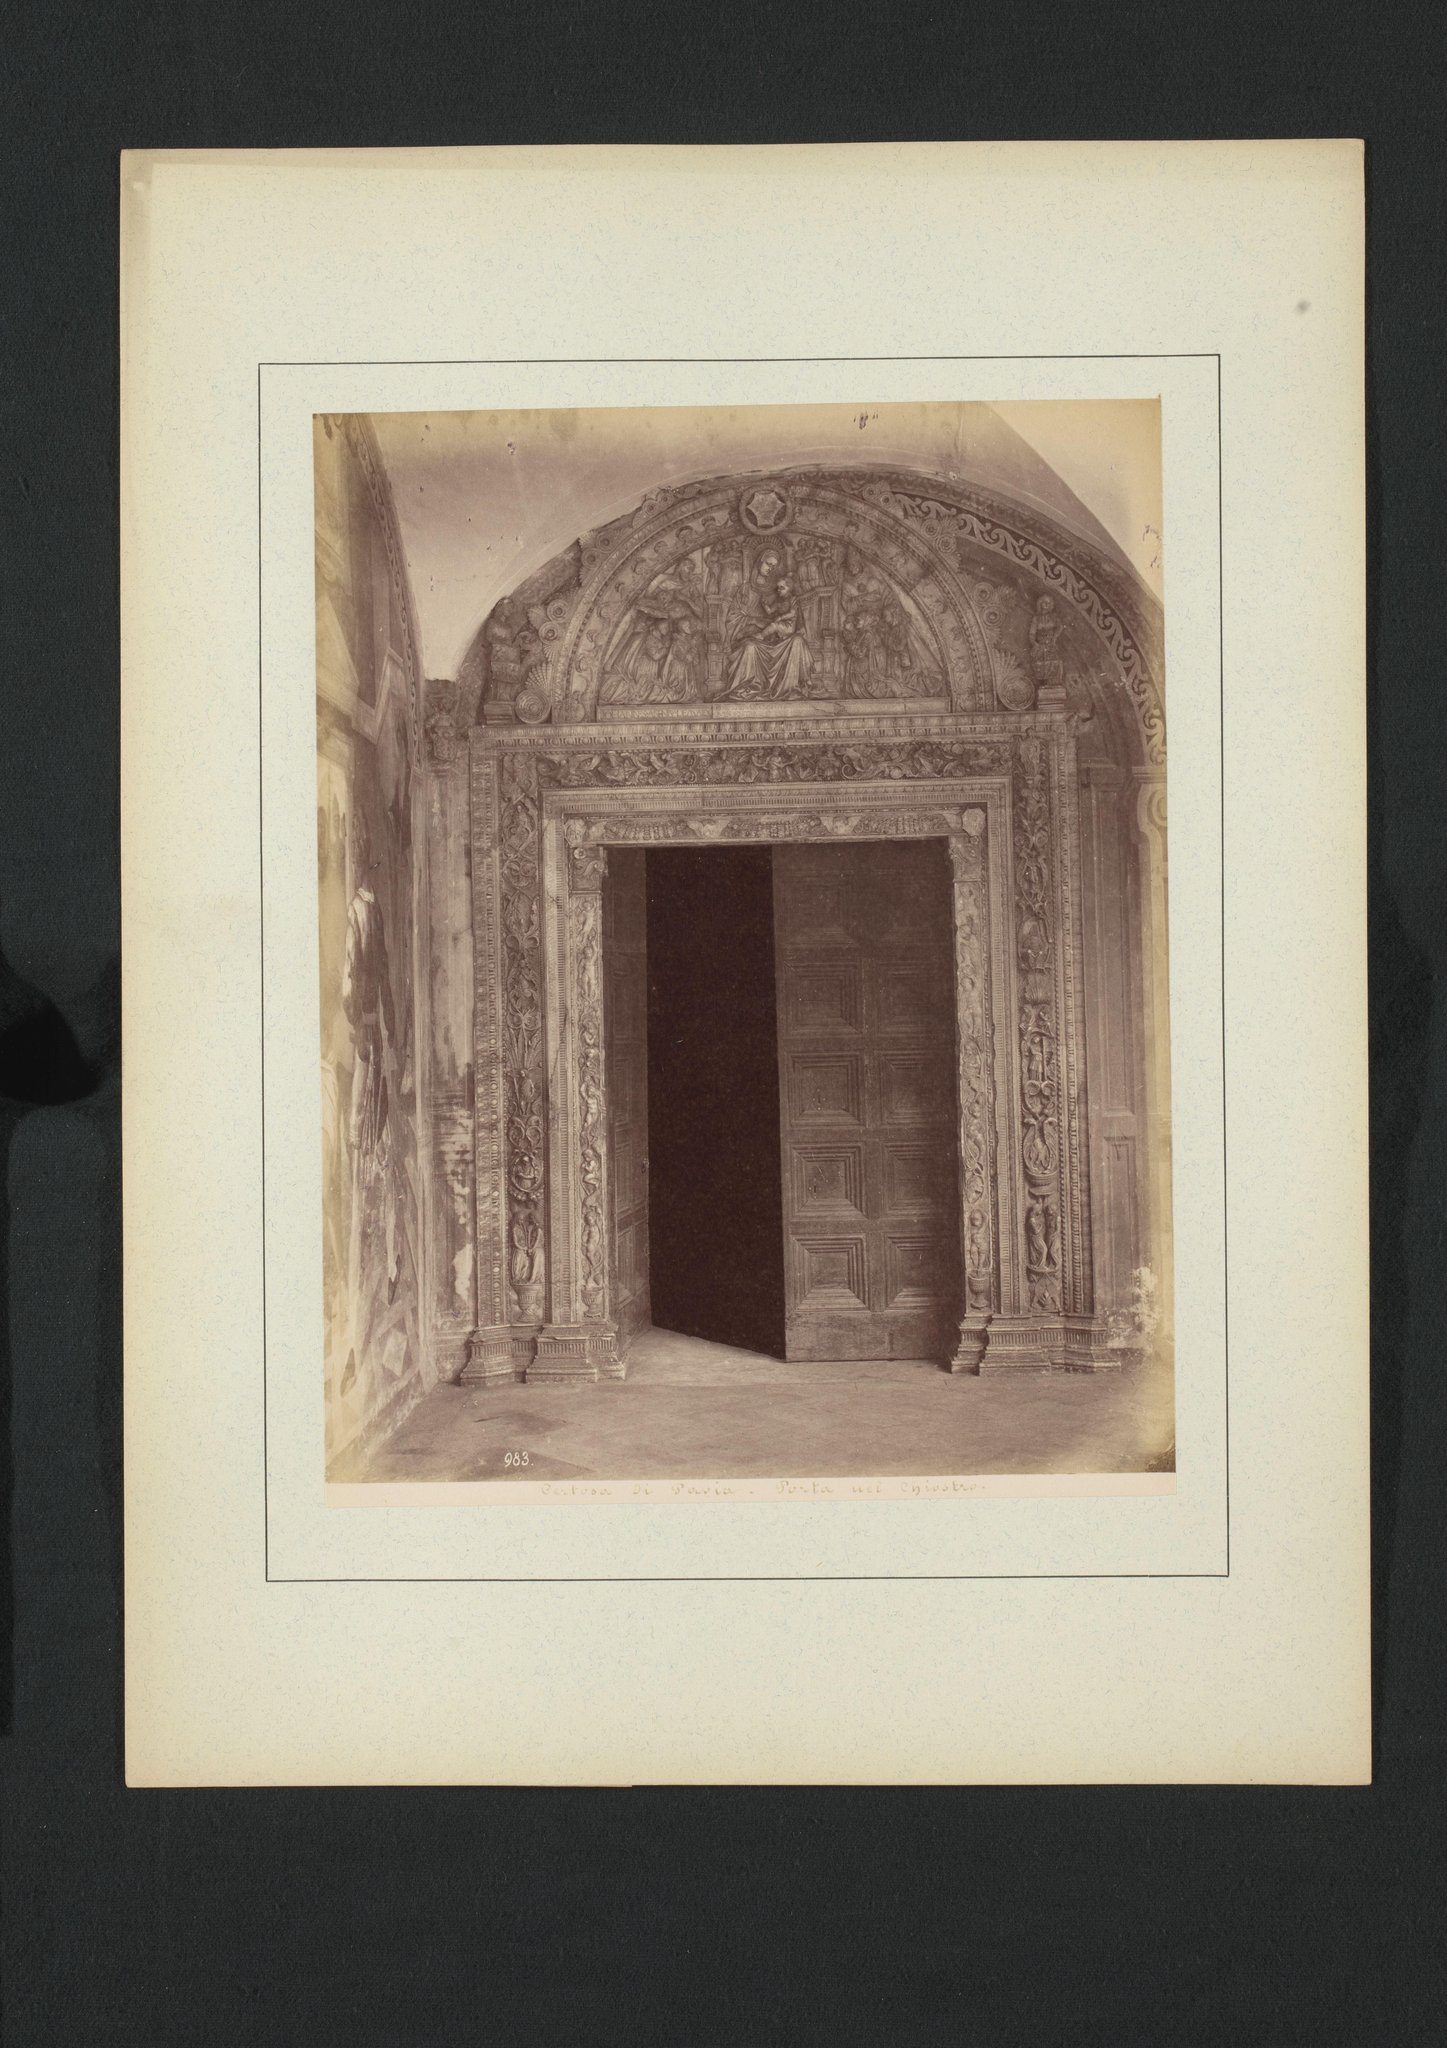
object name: photograph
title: Portaal van het klooster in de Certosa di Pavia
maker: alfredo noack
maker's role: fotograaf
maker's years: 1833-1895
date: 1877-1882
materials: cardboard, photographic support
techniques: albumen print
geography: certosa di pavia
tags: abbey, monastery, convent ~ roman catholic church, gate, entrance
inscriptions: inscription: ‘No. 9. Portal im kleinen Klosterhof’, number: ‘983’